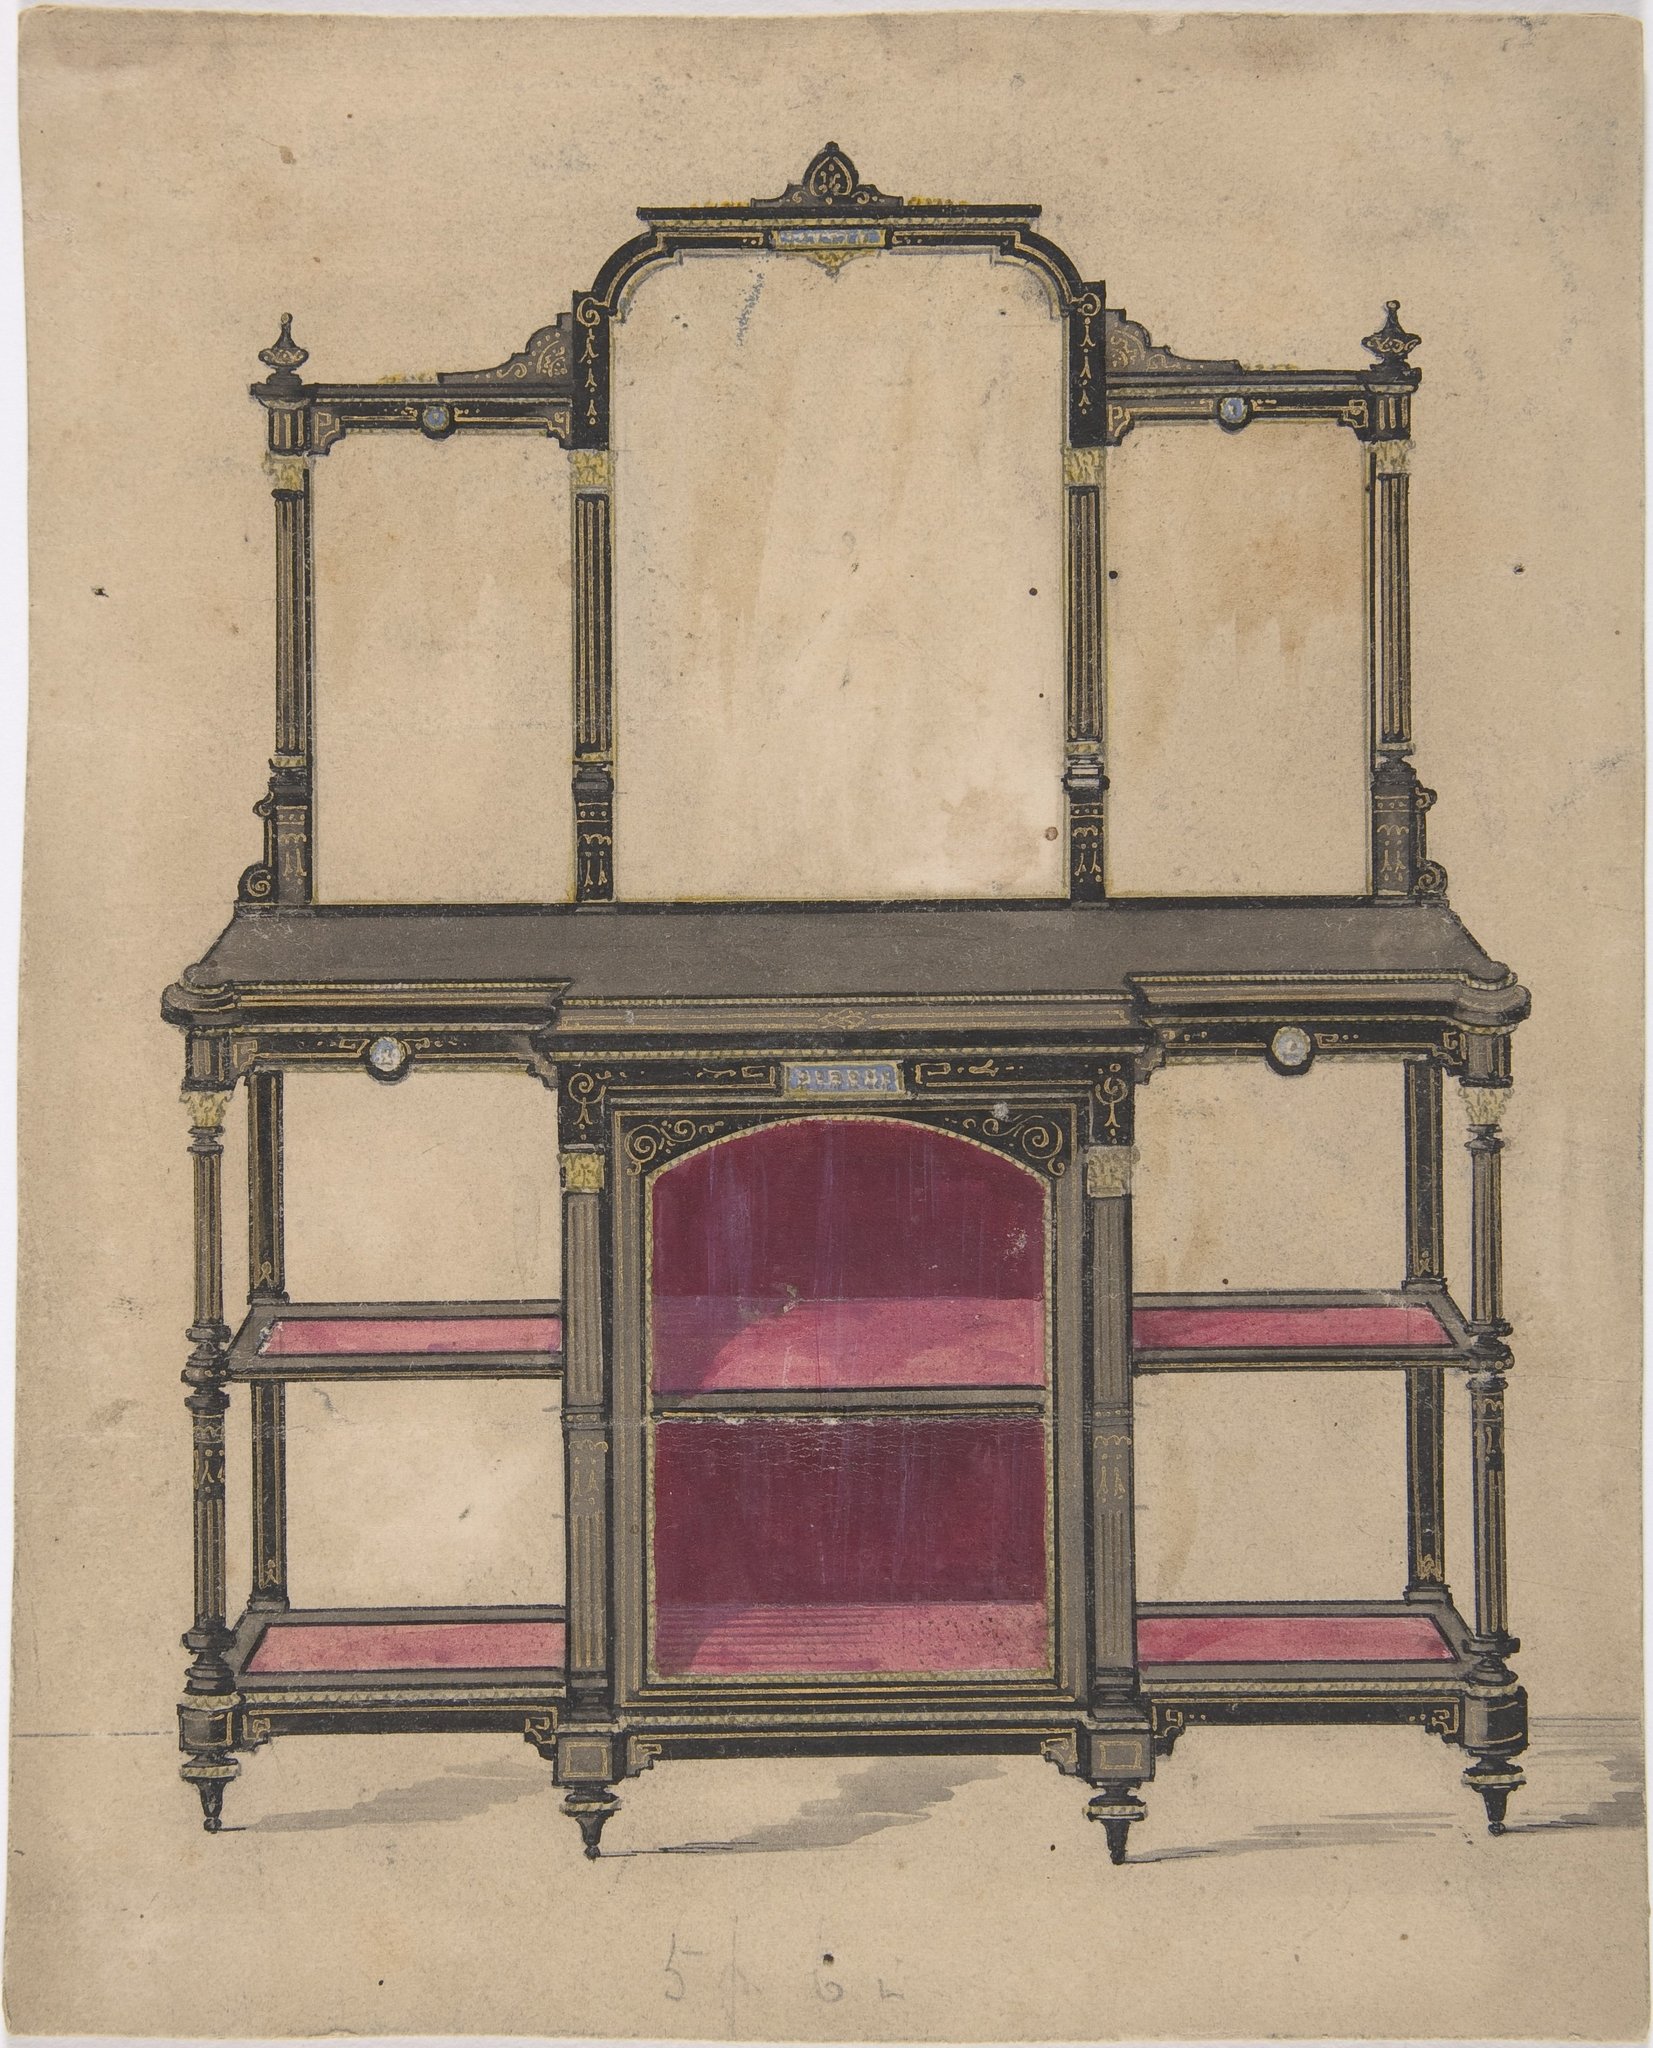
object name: drawing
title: Design for a Cabinet with Shelves and Mirrors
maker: anonymous, british, 19th century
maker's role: artist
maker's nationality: british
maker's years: 1800-1900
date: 1801-1900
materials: ink, watercolor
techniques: pen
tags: cabinets,mirrors